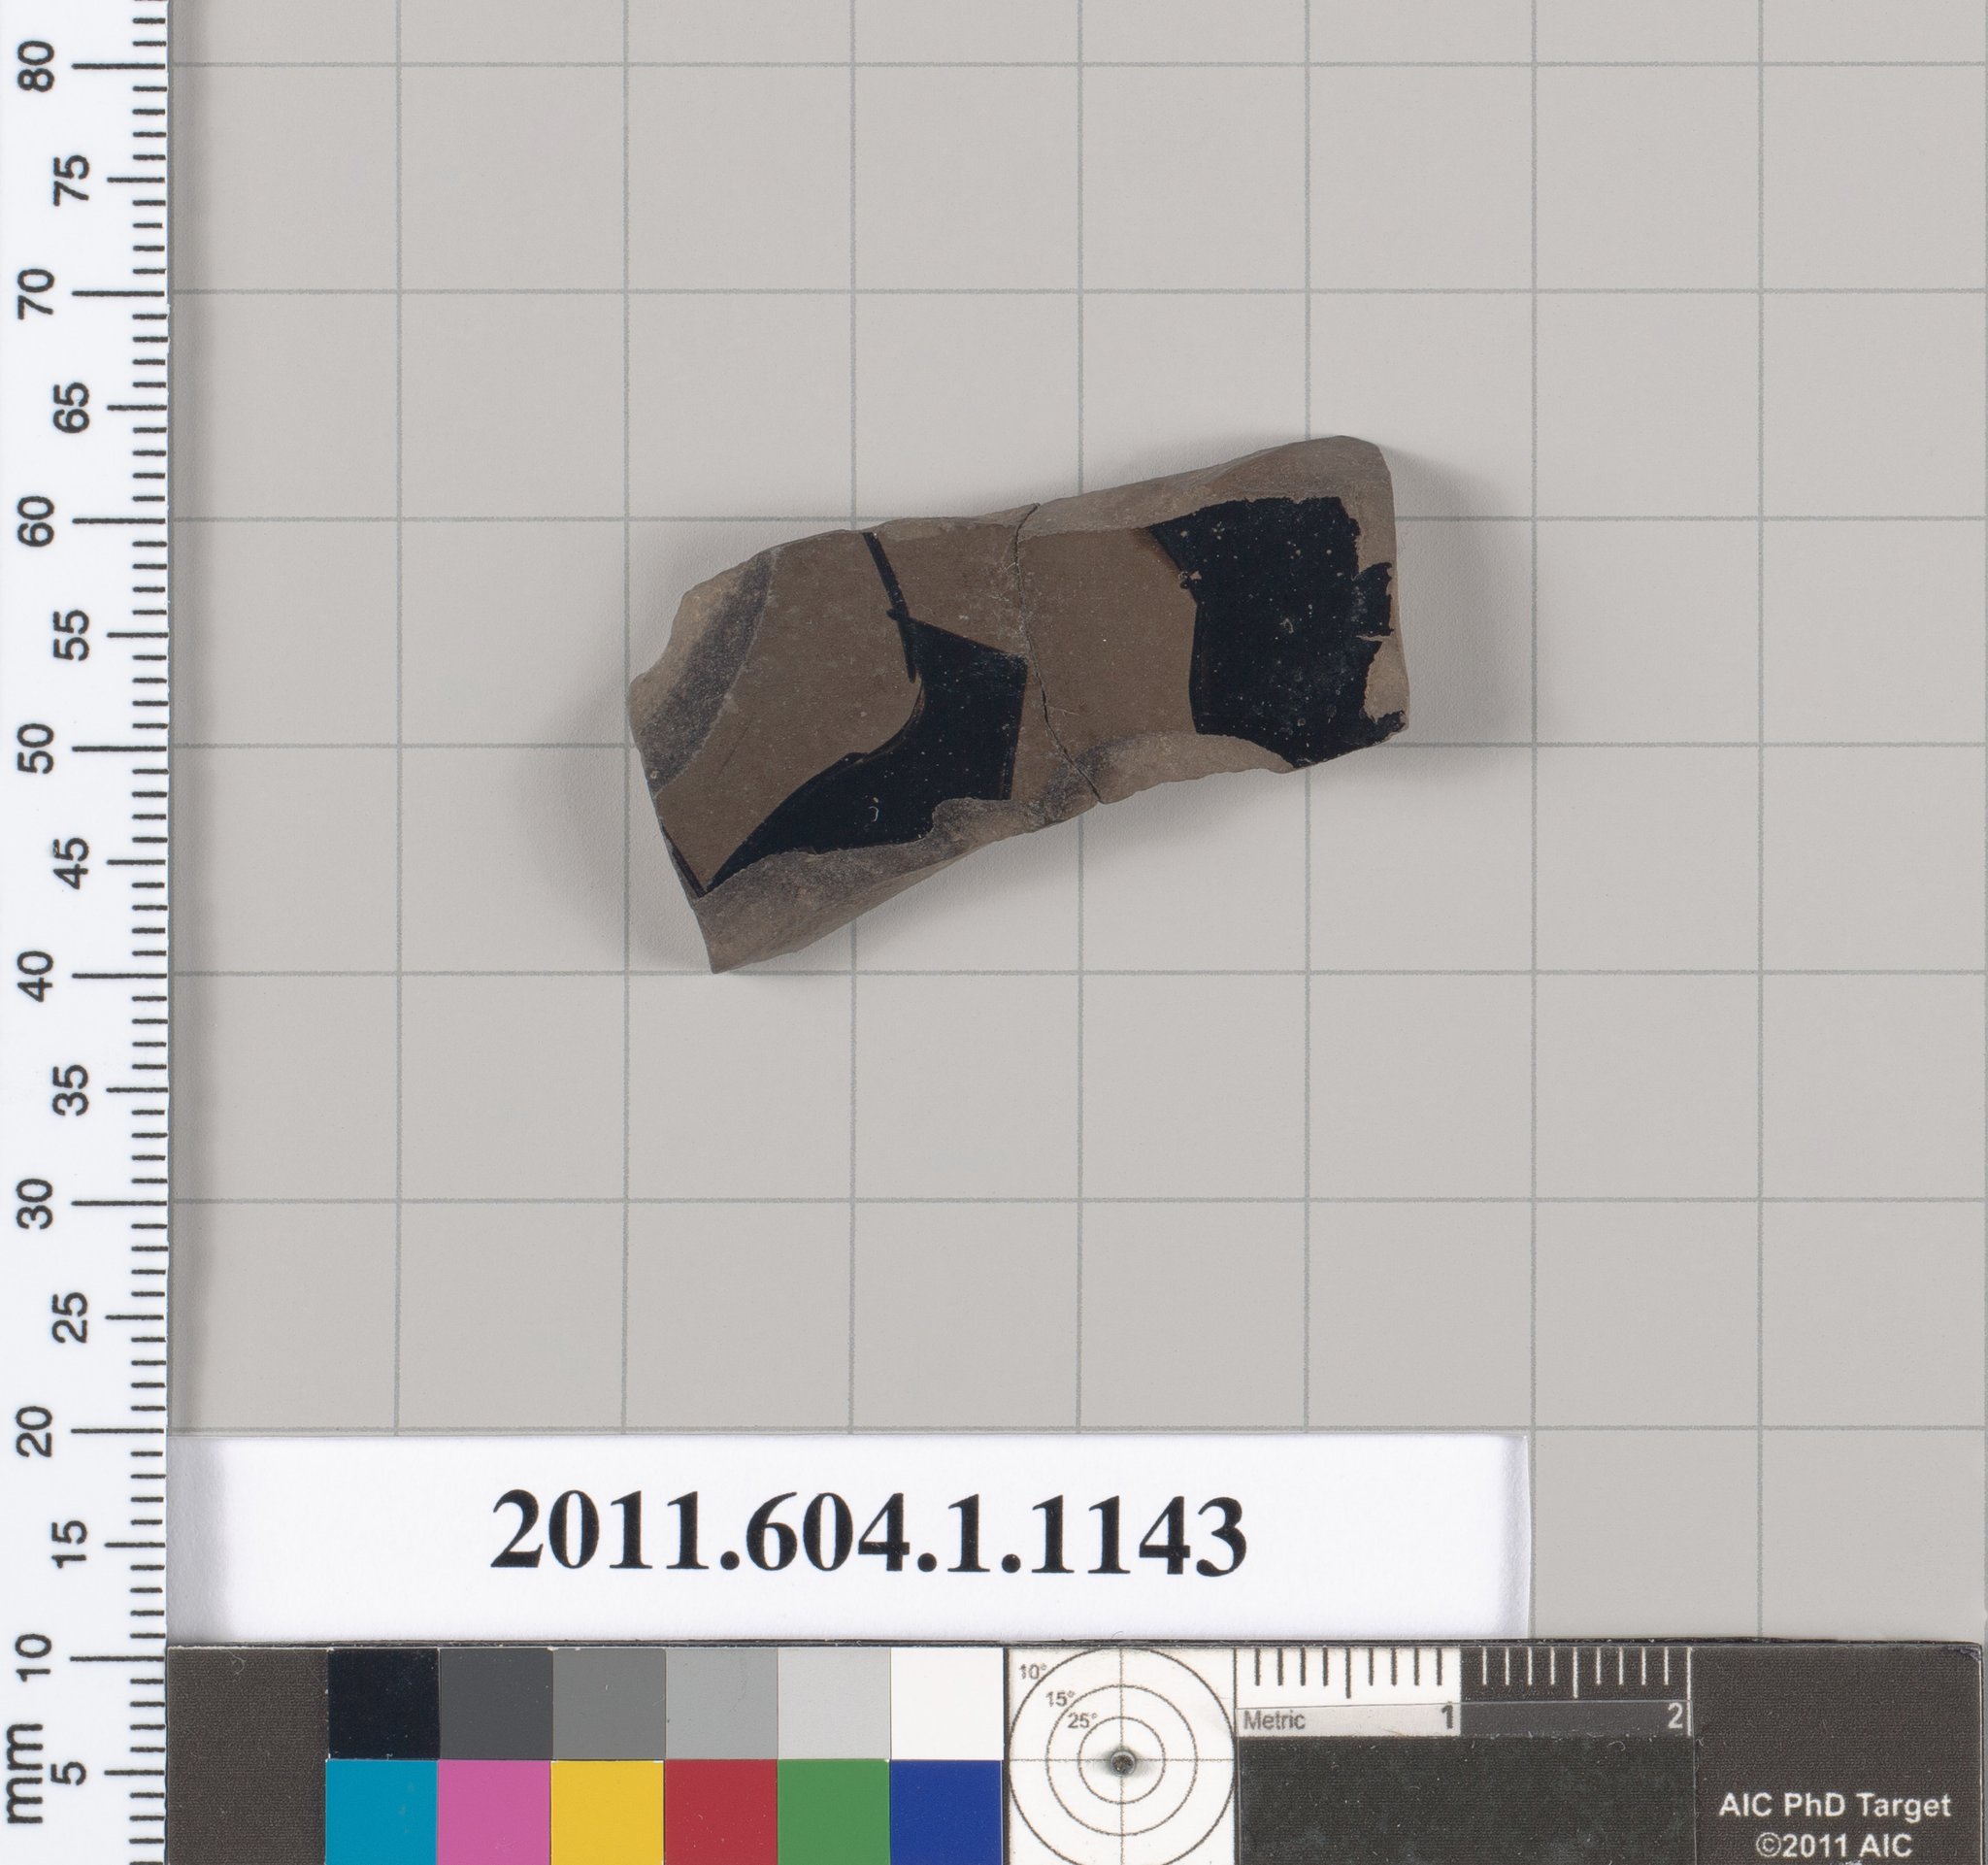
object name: kylix fragment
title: Terracotta fragment of a kylix (drinking cup)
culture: greek, attic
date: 475-451 BCE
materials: terracotta